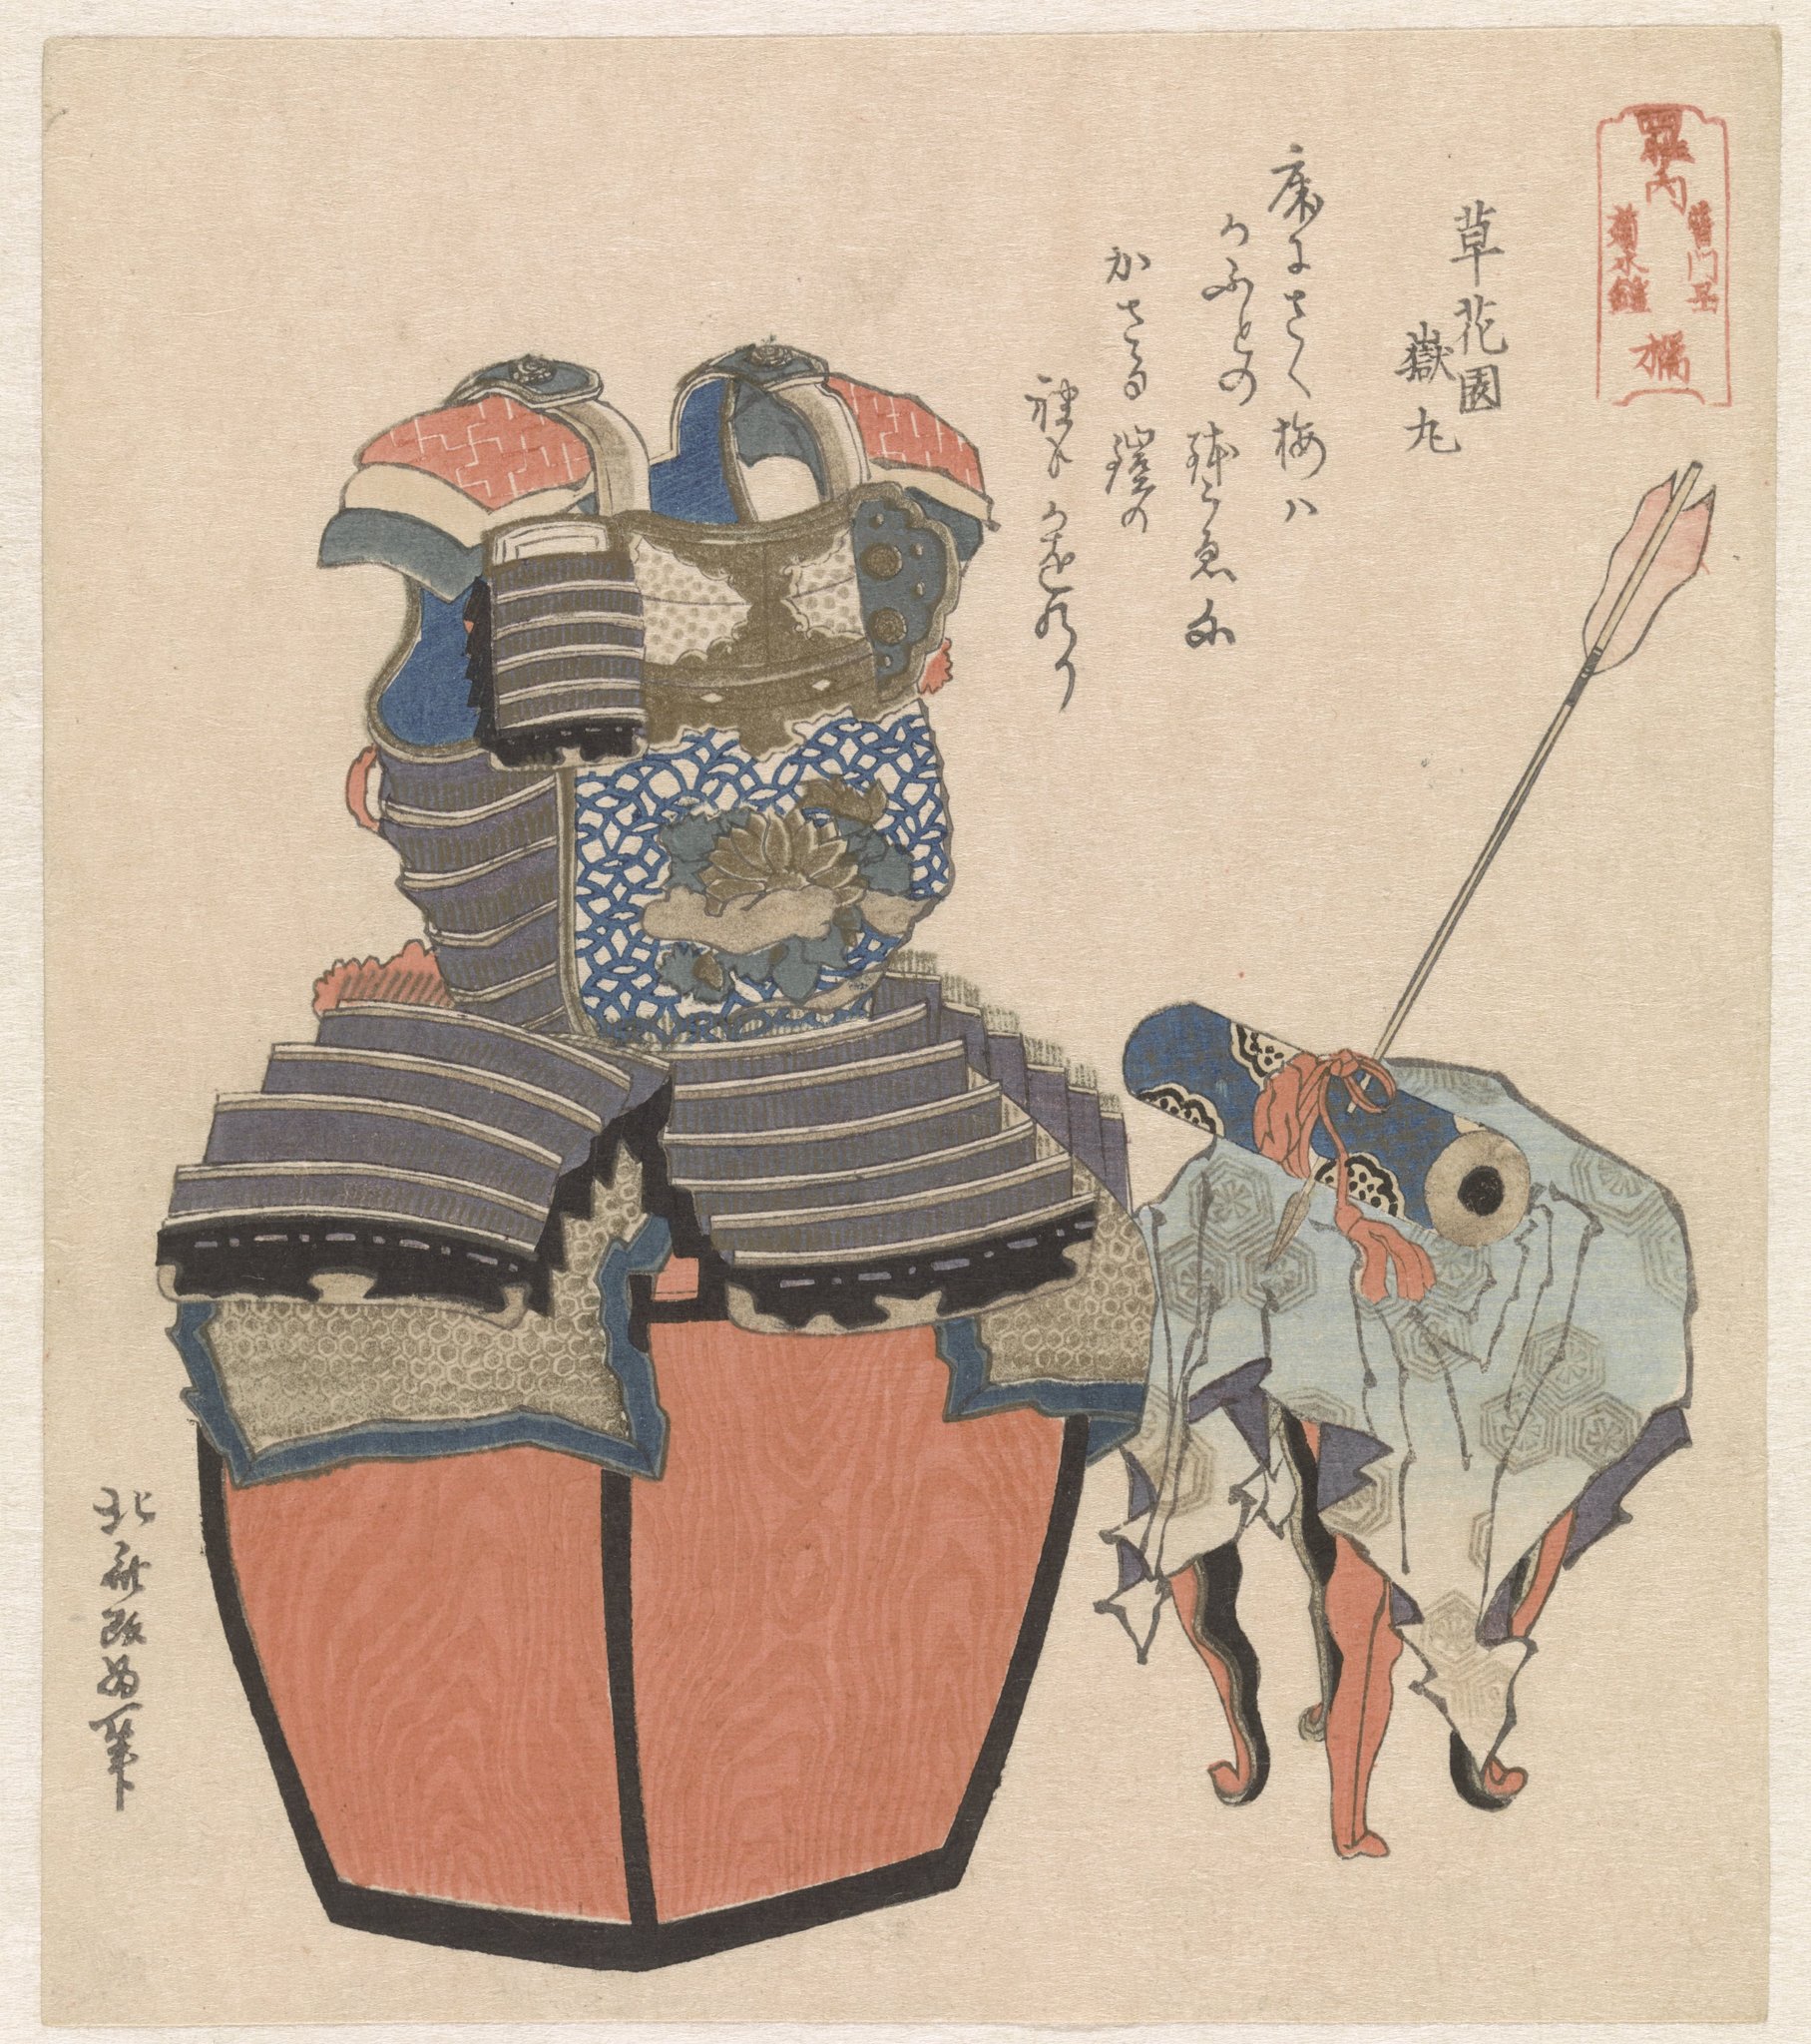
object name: print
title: Tachibana - Fumonbon Kikusuiyoroi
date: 1890-1900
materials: paper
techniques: woodcut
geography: japan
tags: armour, armorial bearing, heraldry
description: Een surimono is een luxe uitgevoerde prent waarop beeld met één of meerdere gedichten gecombineerd is. Bij het drukken van een surimono werd vaak gebruik gemaakt van dikker papier, blinddruk en metaal pigmenten, zoals koper- en zilverpoeder. De prenten werden vaak in opdracht van dichters gemaakt en als exclusief geschenk aan vrienden en relaties gegeven.